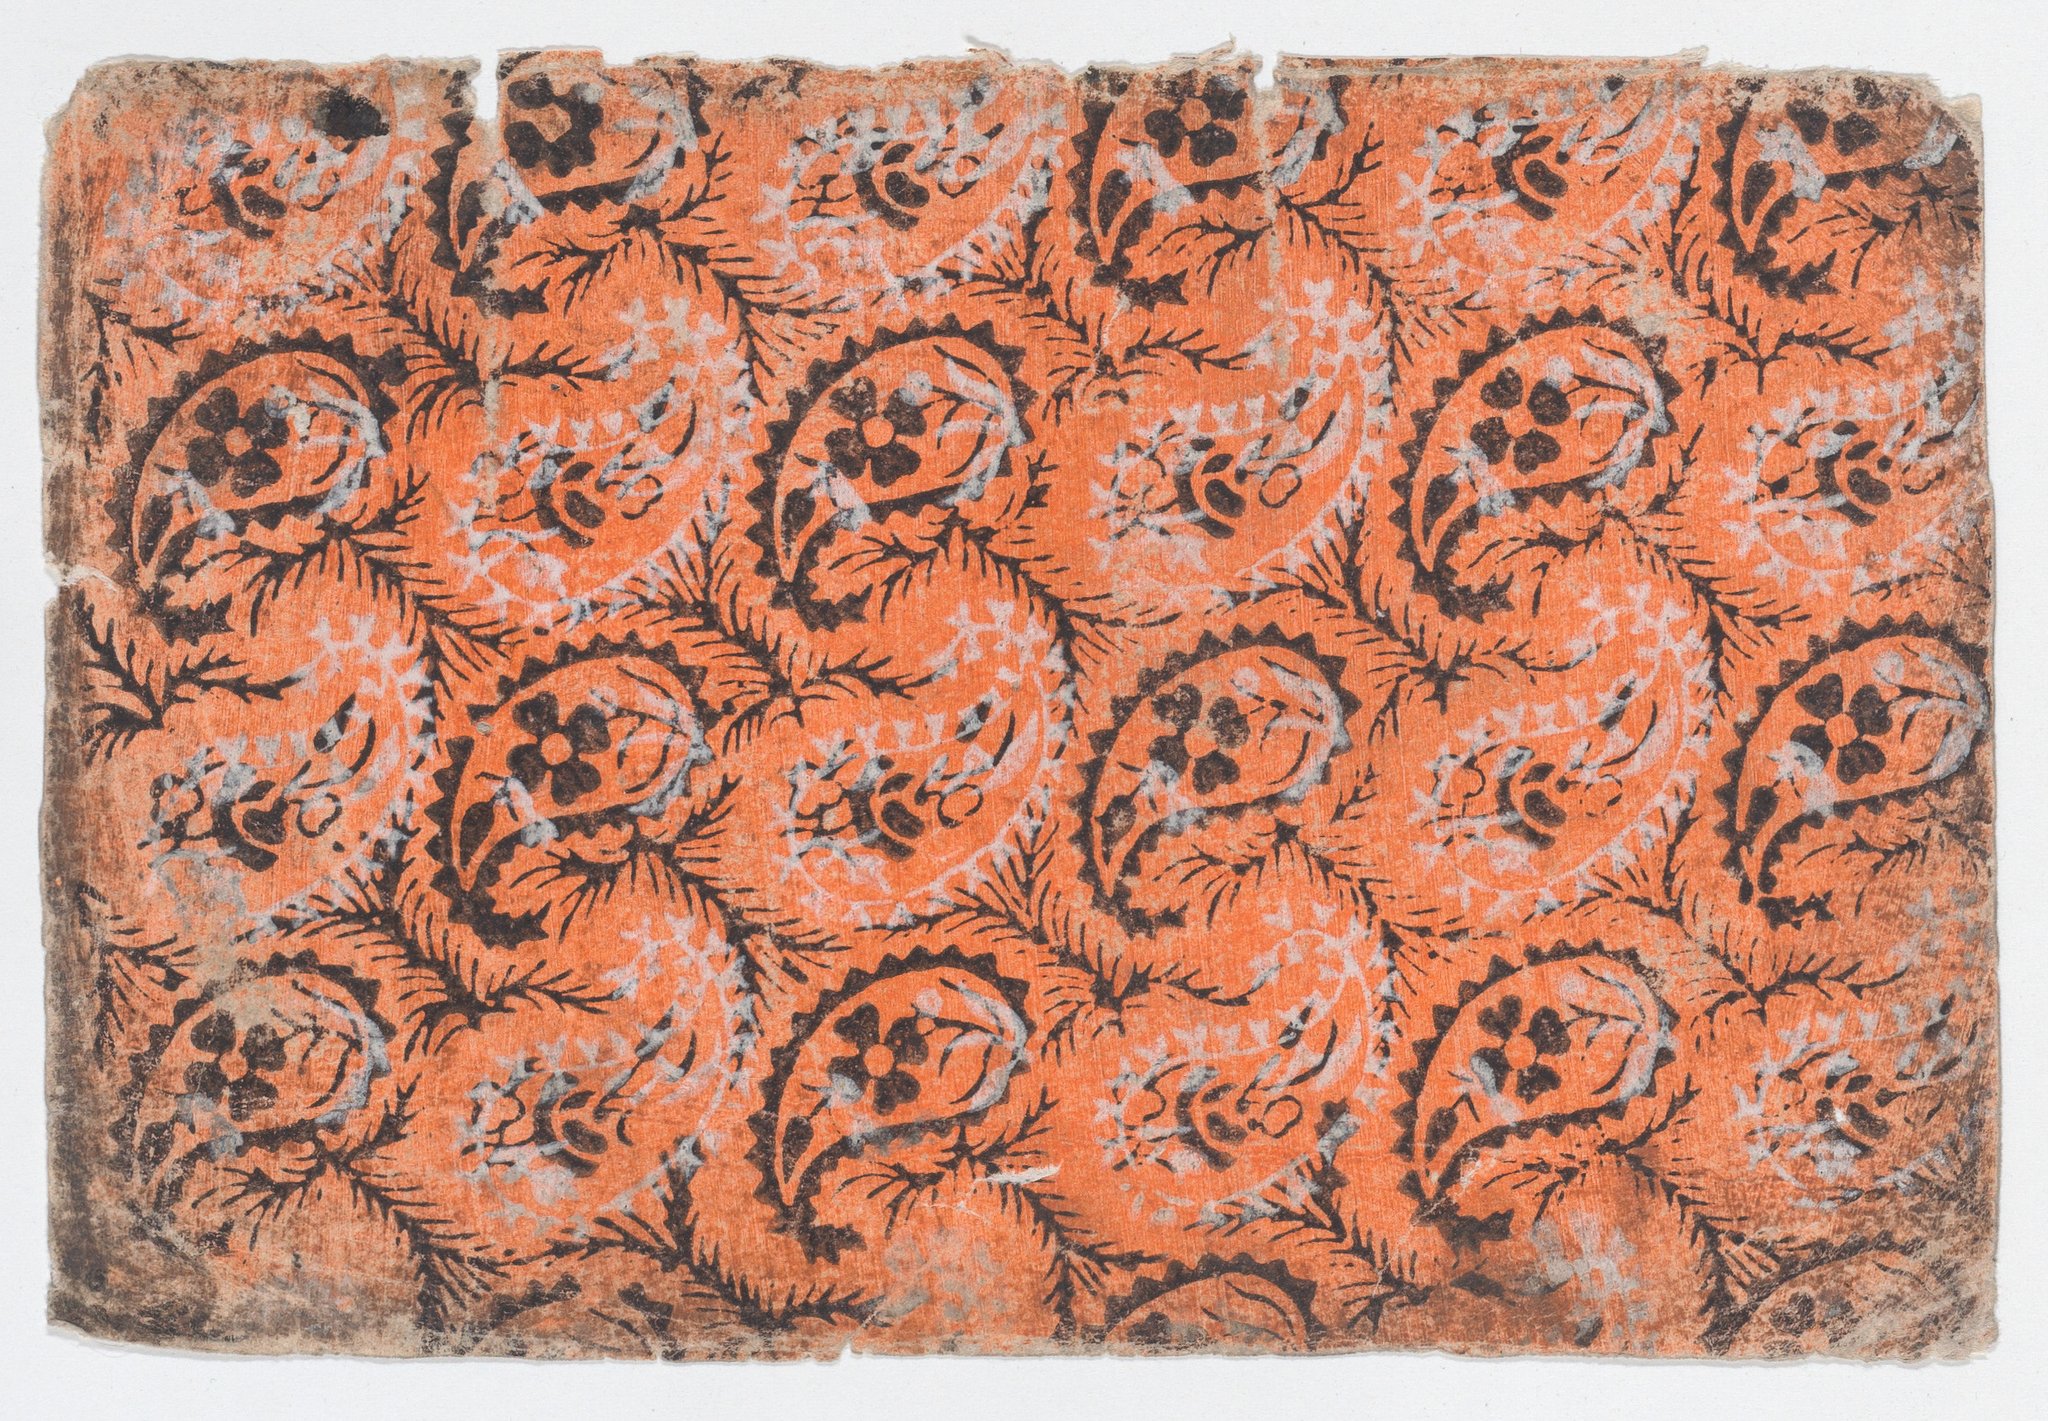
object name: print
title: Sheet with overall paisley pattern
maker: Anonymous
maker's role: artist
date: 1801-1900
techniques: relief print